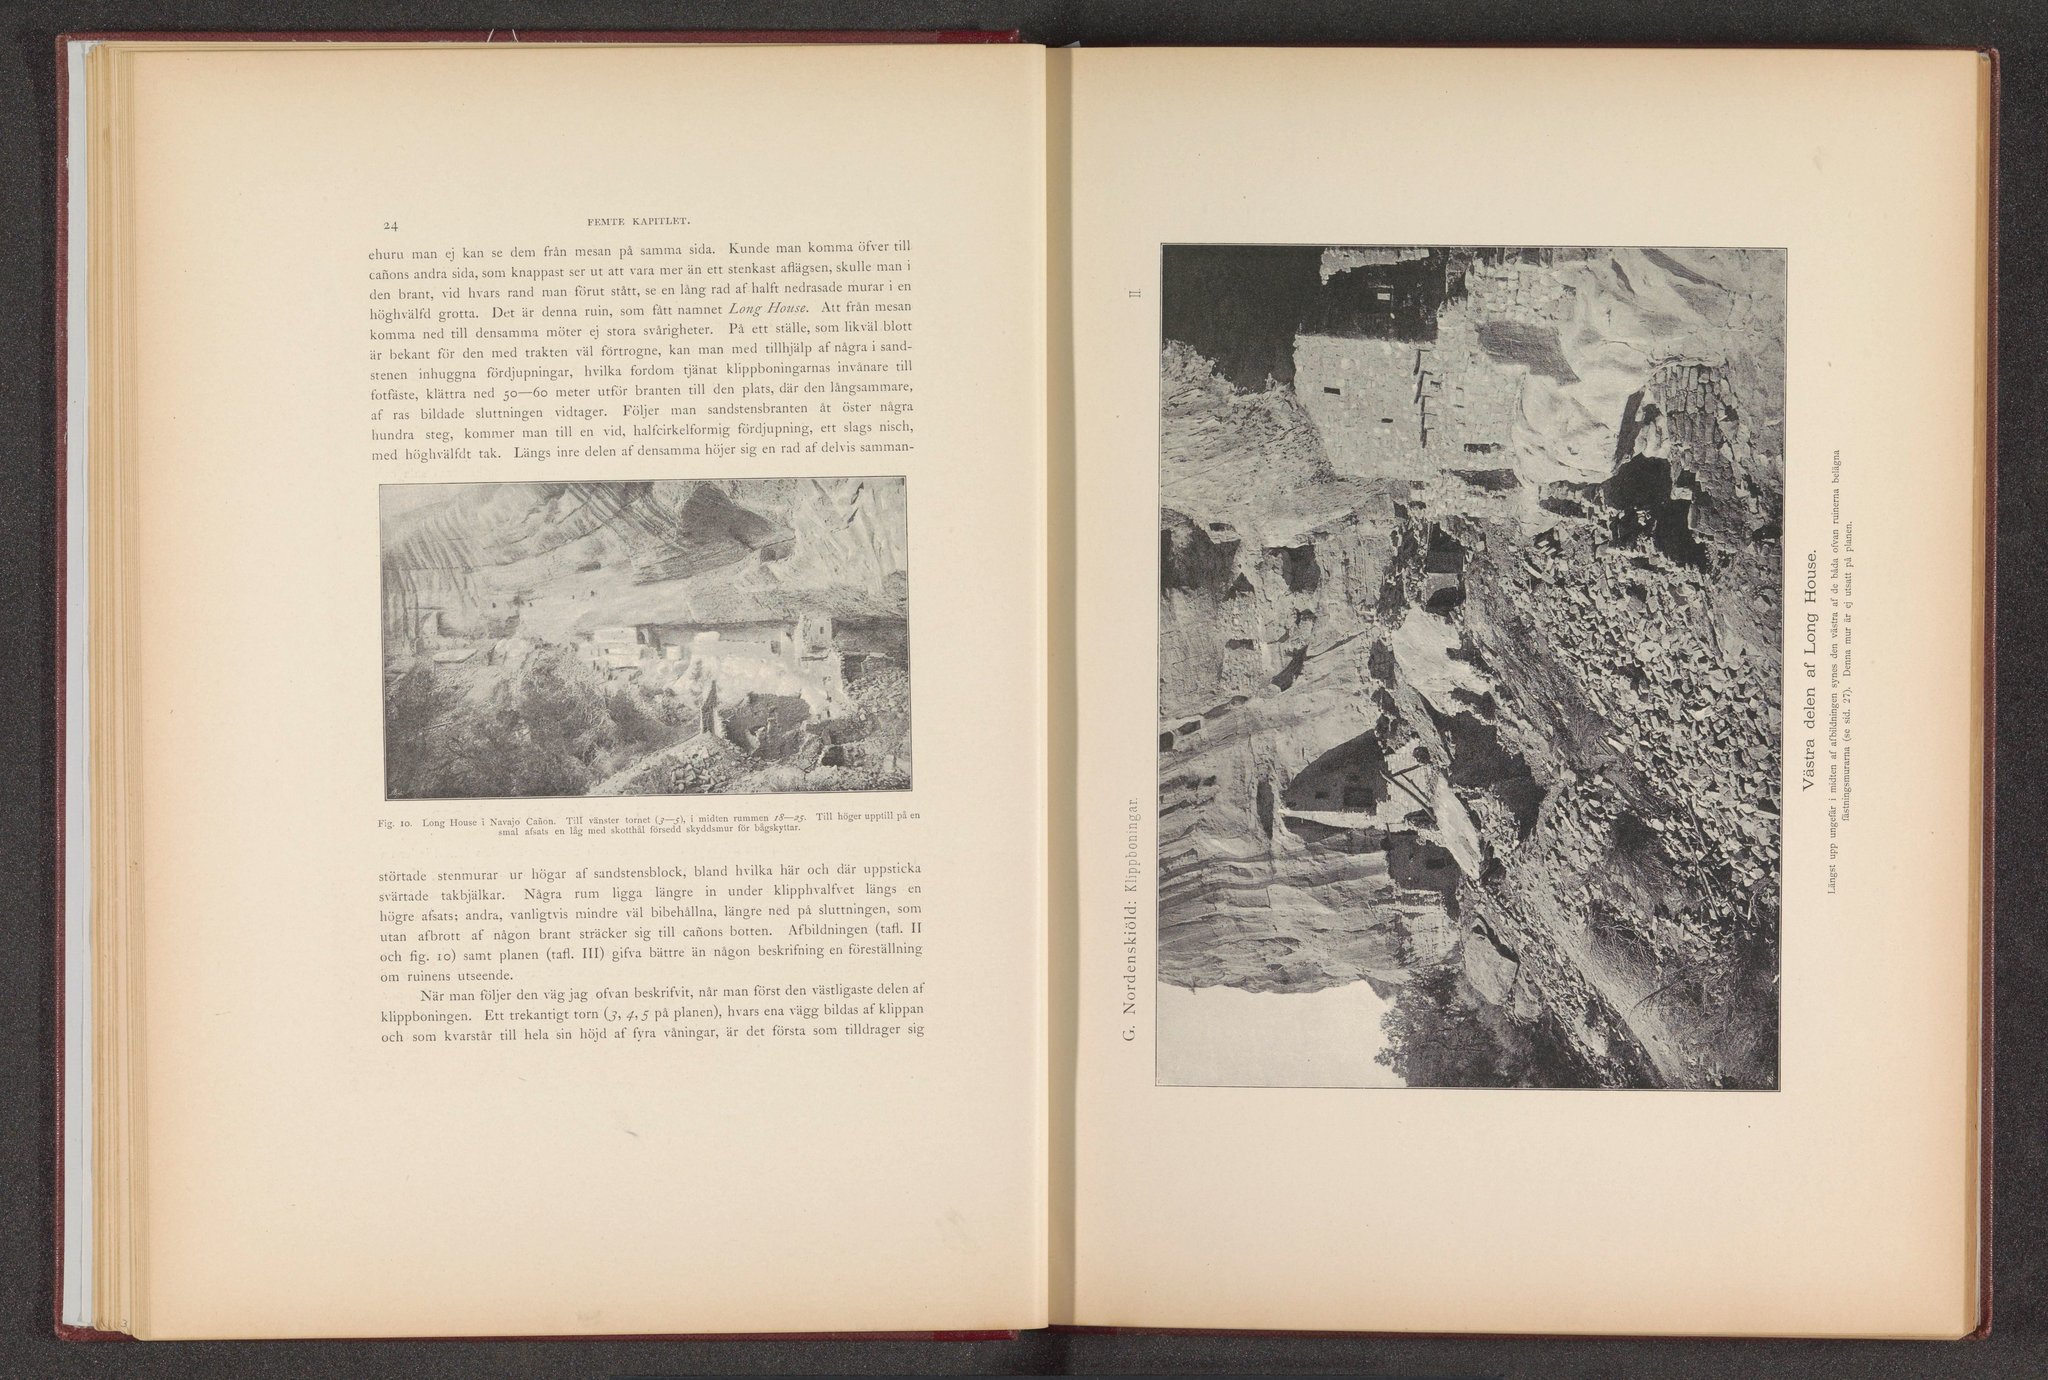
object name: photomechanical print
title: Gezicht op de westelijke delen van Long House in Mesa Verde National Park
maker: gustaf nordenskiöld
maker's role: fotograaf, schrijver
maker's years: 1868-1895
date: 1891-1893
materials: paper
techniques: autotype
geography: vienna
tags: cave-dwelling, ruin of a dwelling, house, castle, etc.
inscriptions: number: ‘II.’, inscription: ‘G. Nordenskiöld: Klippboningar.’, name